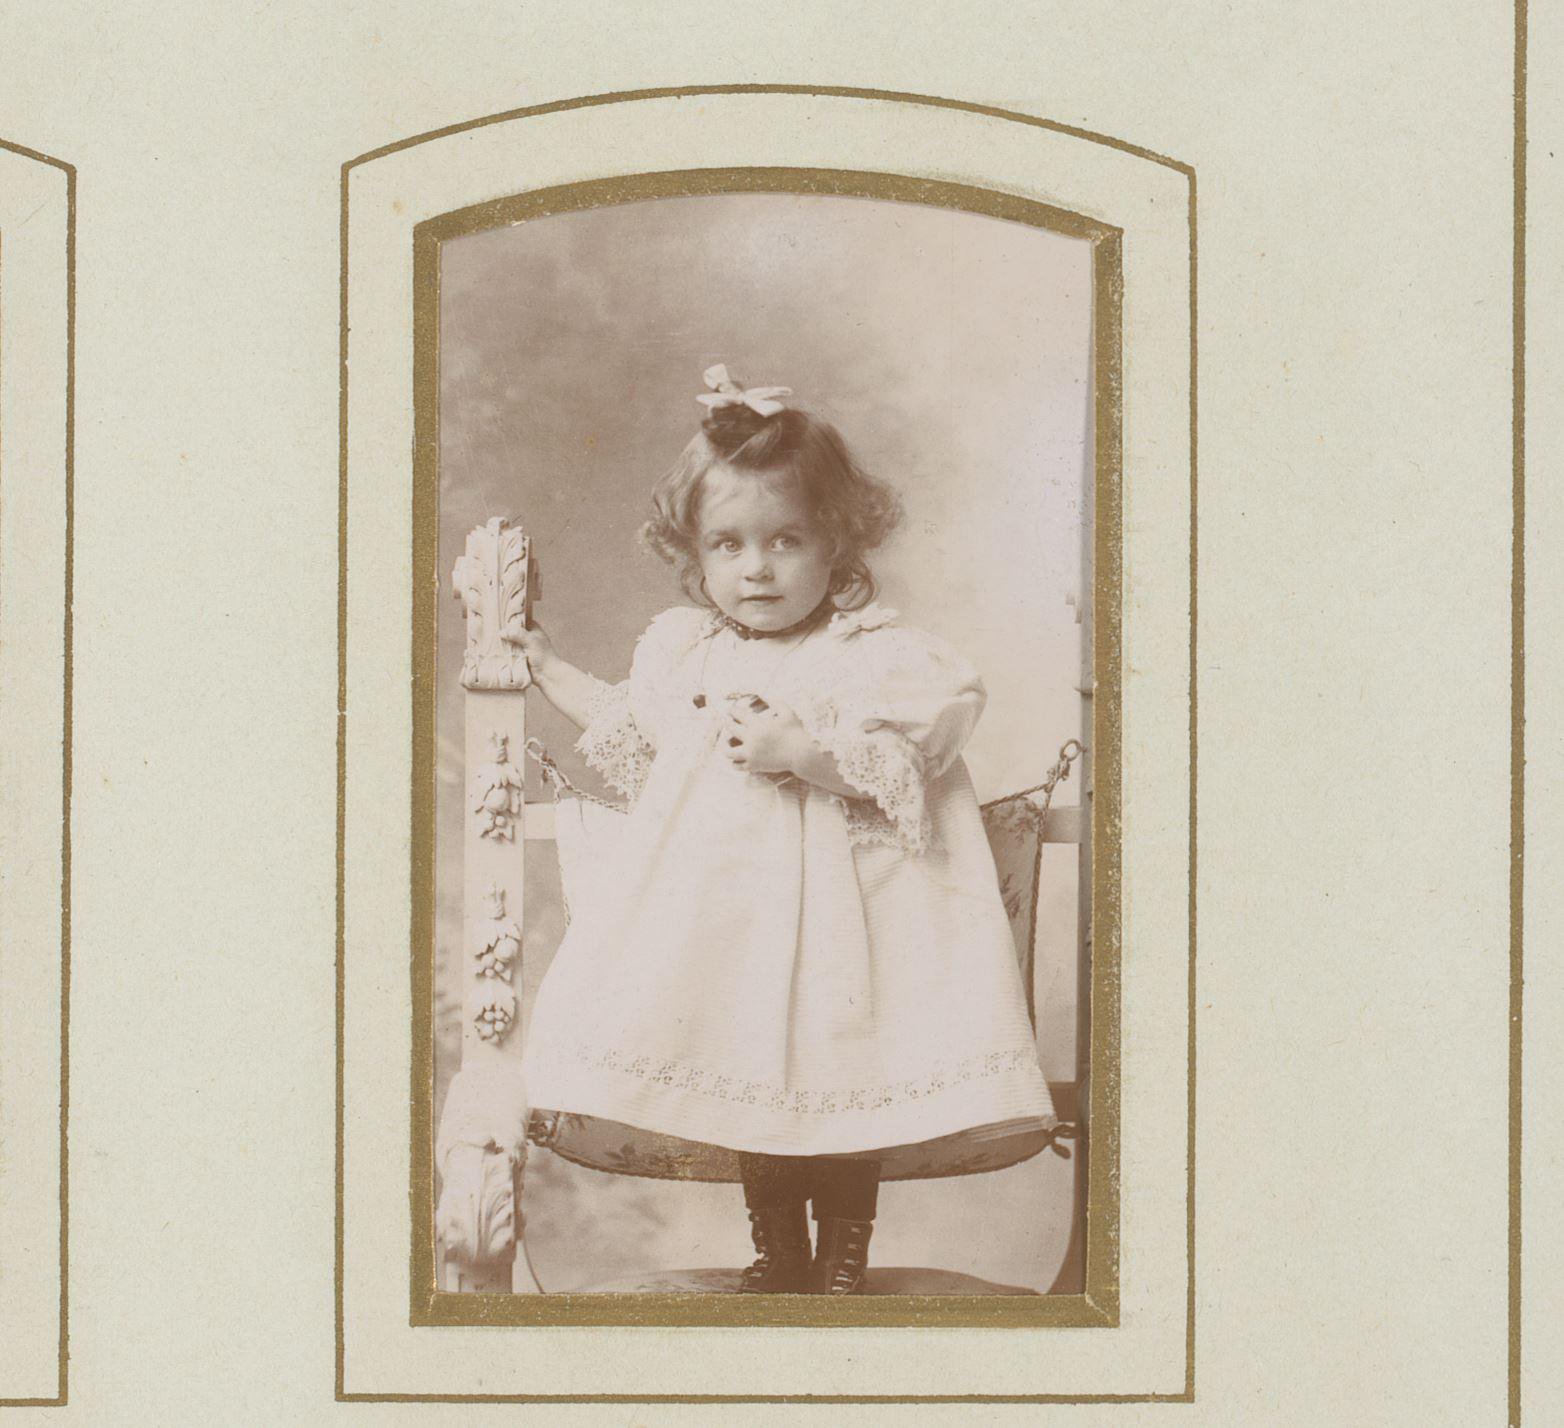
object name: photograph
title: Portret van Madeleine Verluise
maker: alphonse théodore acquart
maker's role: fotograaf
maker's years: 1859-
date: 1880-1920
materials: cardboard, photographic support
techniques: collodion silver print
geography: vincennes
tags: historical persons - bb - woman, toddler (female)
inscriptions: inscription: ‘PHOTOGRAPHIE/ MAISON FONDÉE EN 1875/ Acquart/ 45, Cours Marigny/ à/ Vincennes’, name: ‘Madeleine Verluise’